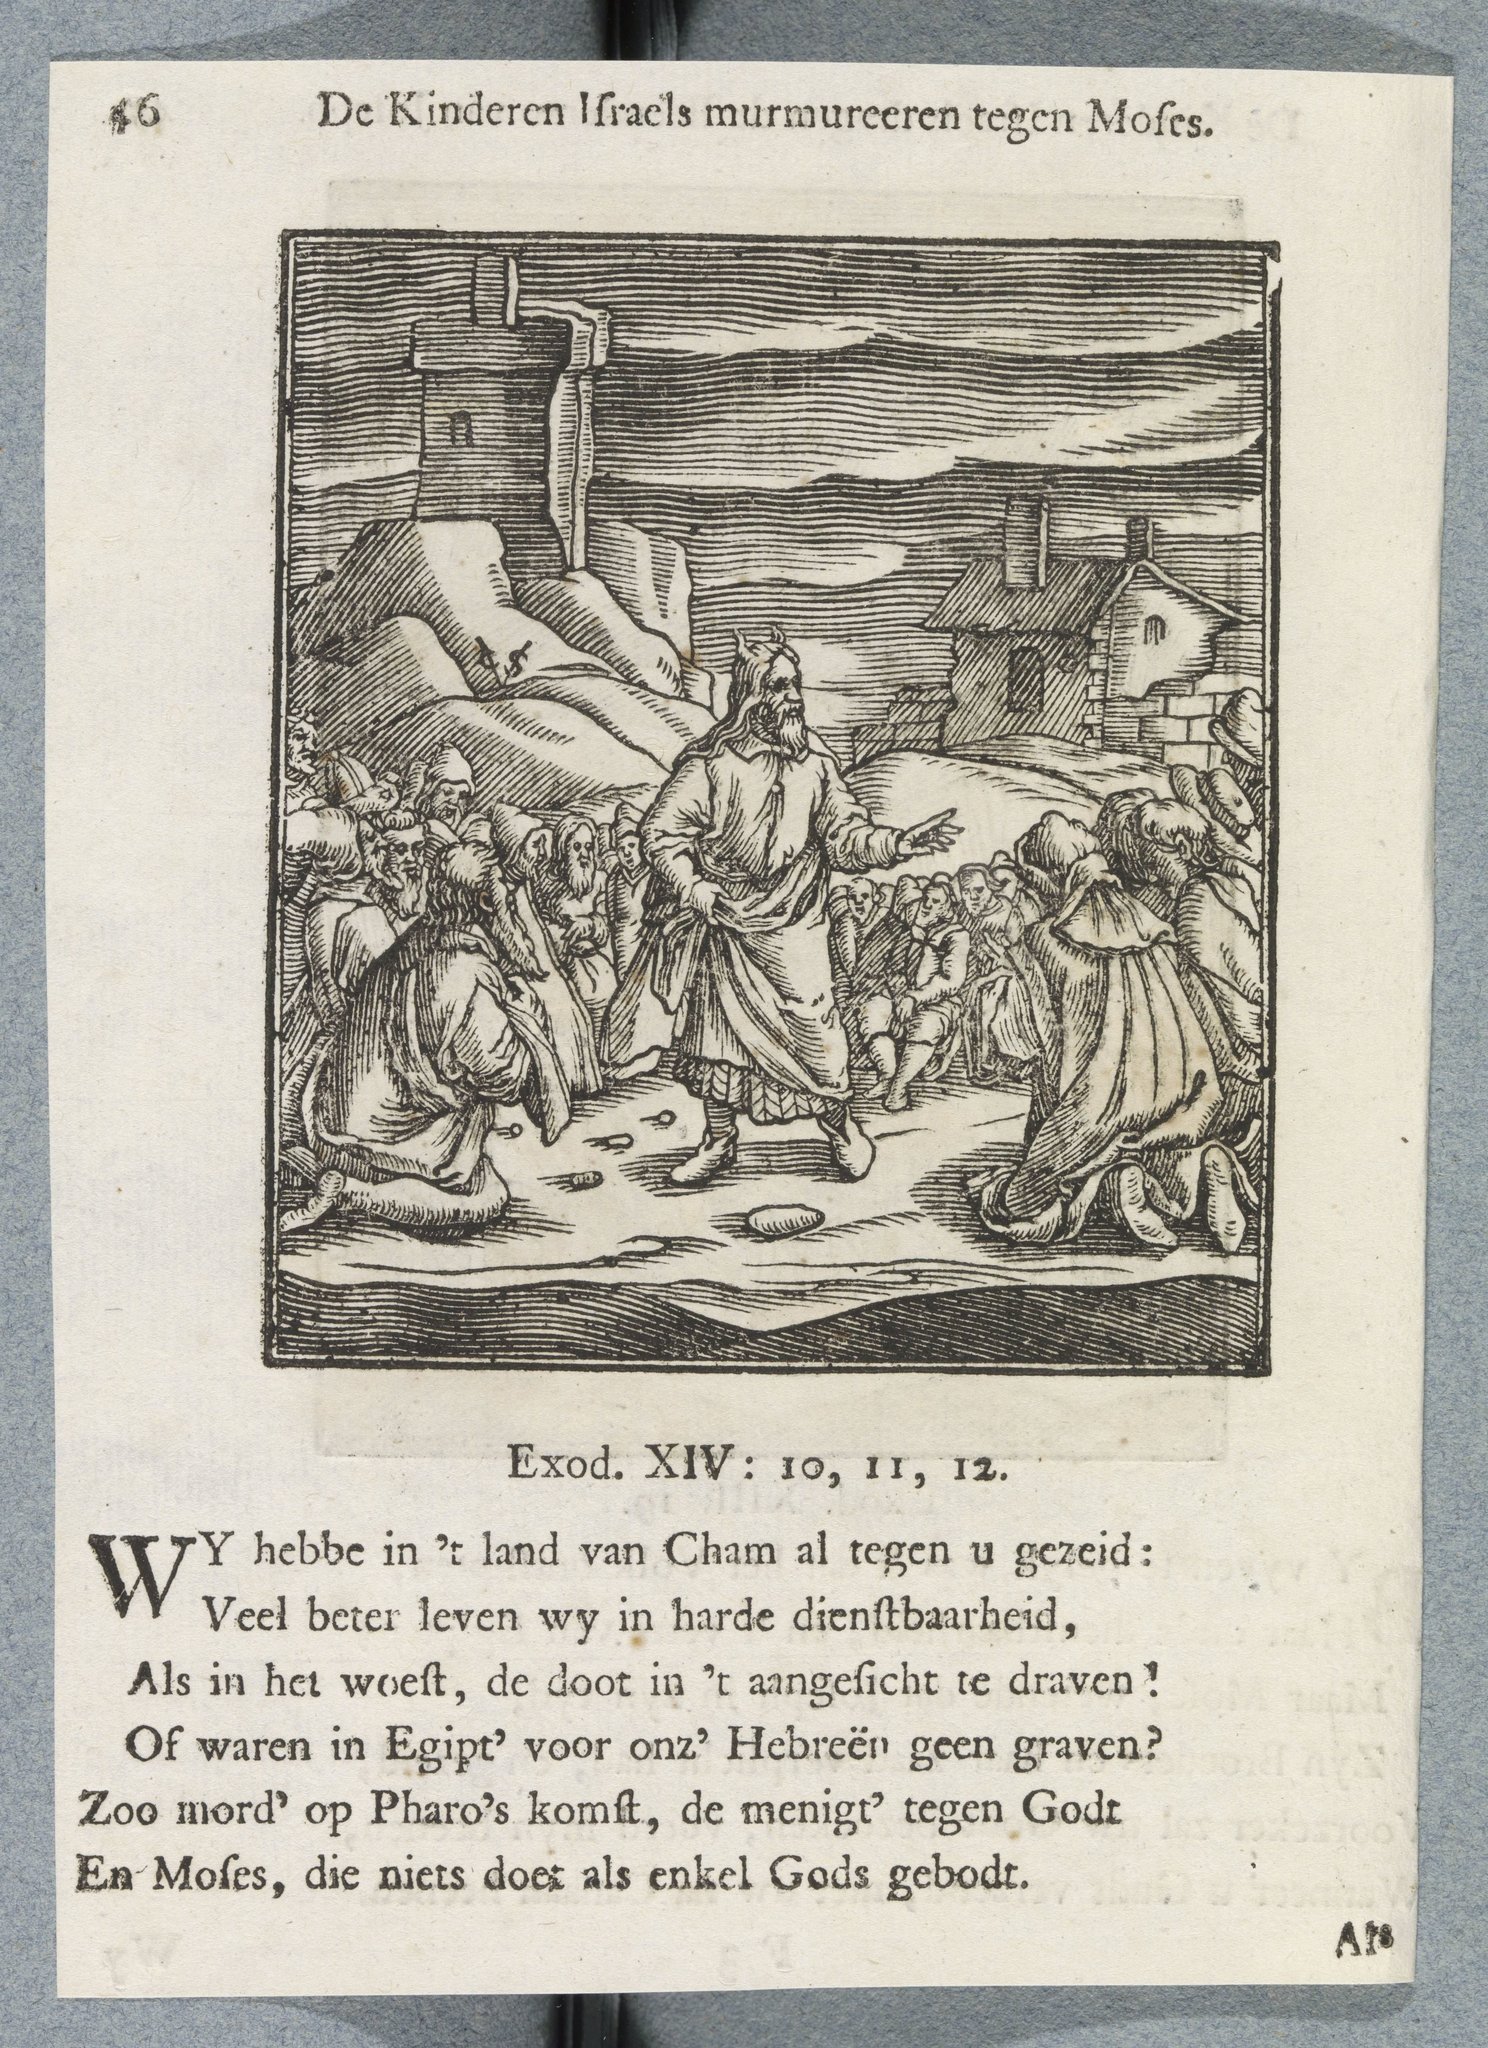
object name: book illustration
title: De kinderen Israëls murmureeren tegen Moses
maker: jan klooster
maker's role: bookseller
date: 1645-1646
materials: paper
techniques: letterpress printing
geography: amsterdam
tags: the people of israel murmur against moses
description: De prent is afkomstig uit: Bybels Lusthof. Amsterdam, J. Klooster, 1740. De prent werd gemaakt voor de uitgaven van P.J. Paets uit Amsterdam. Ze komt in ieder geval voor in: Bibels Tresoor ofte der zielen lusthof. Amsterdam, P.J. Paets, 1646. Mogelijk staat ze ook in: Historien ende Prophetien. [Amsterdam], P.J. Paets, 1645.